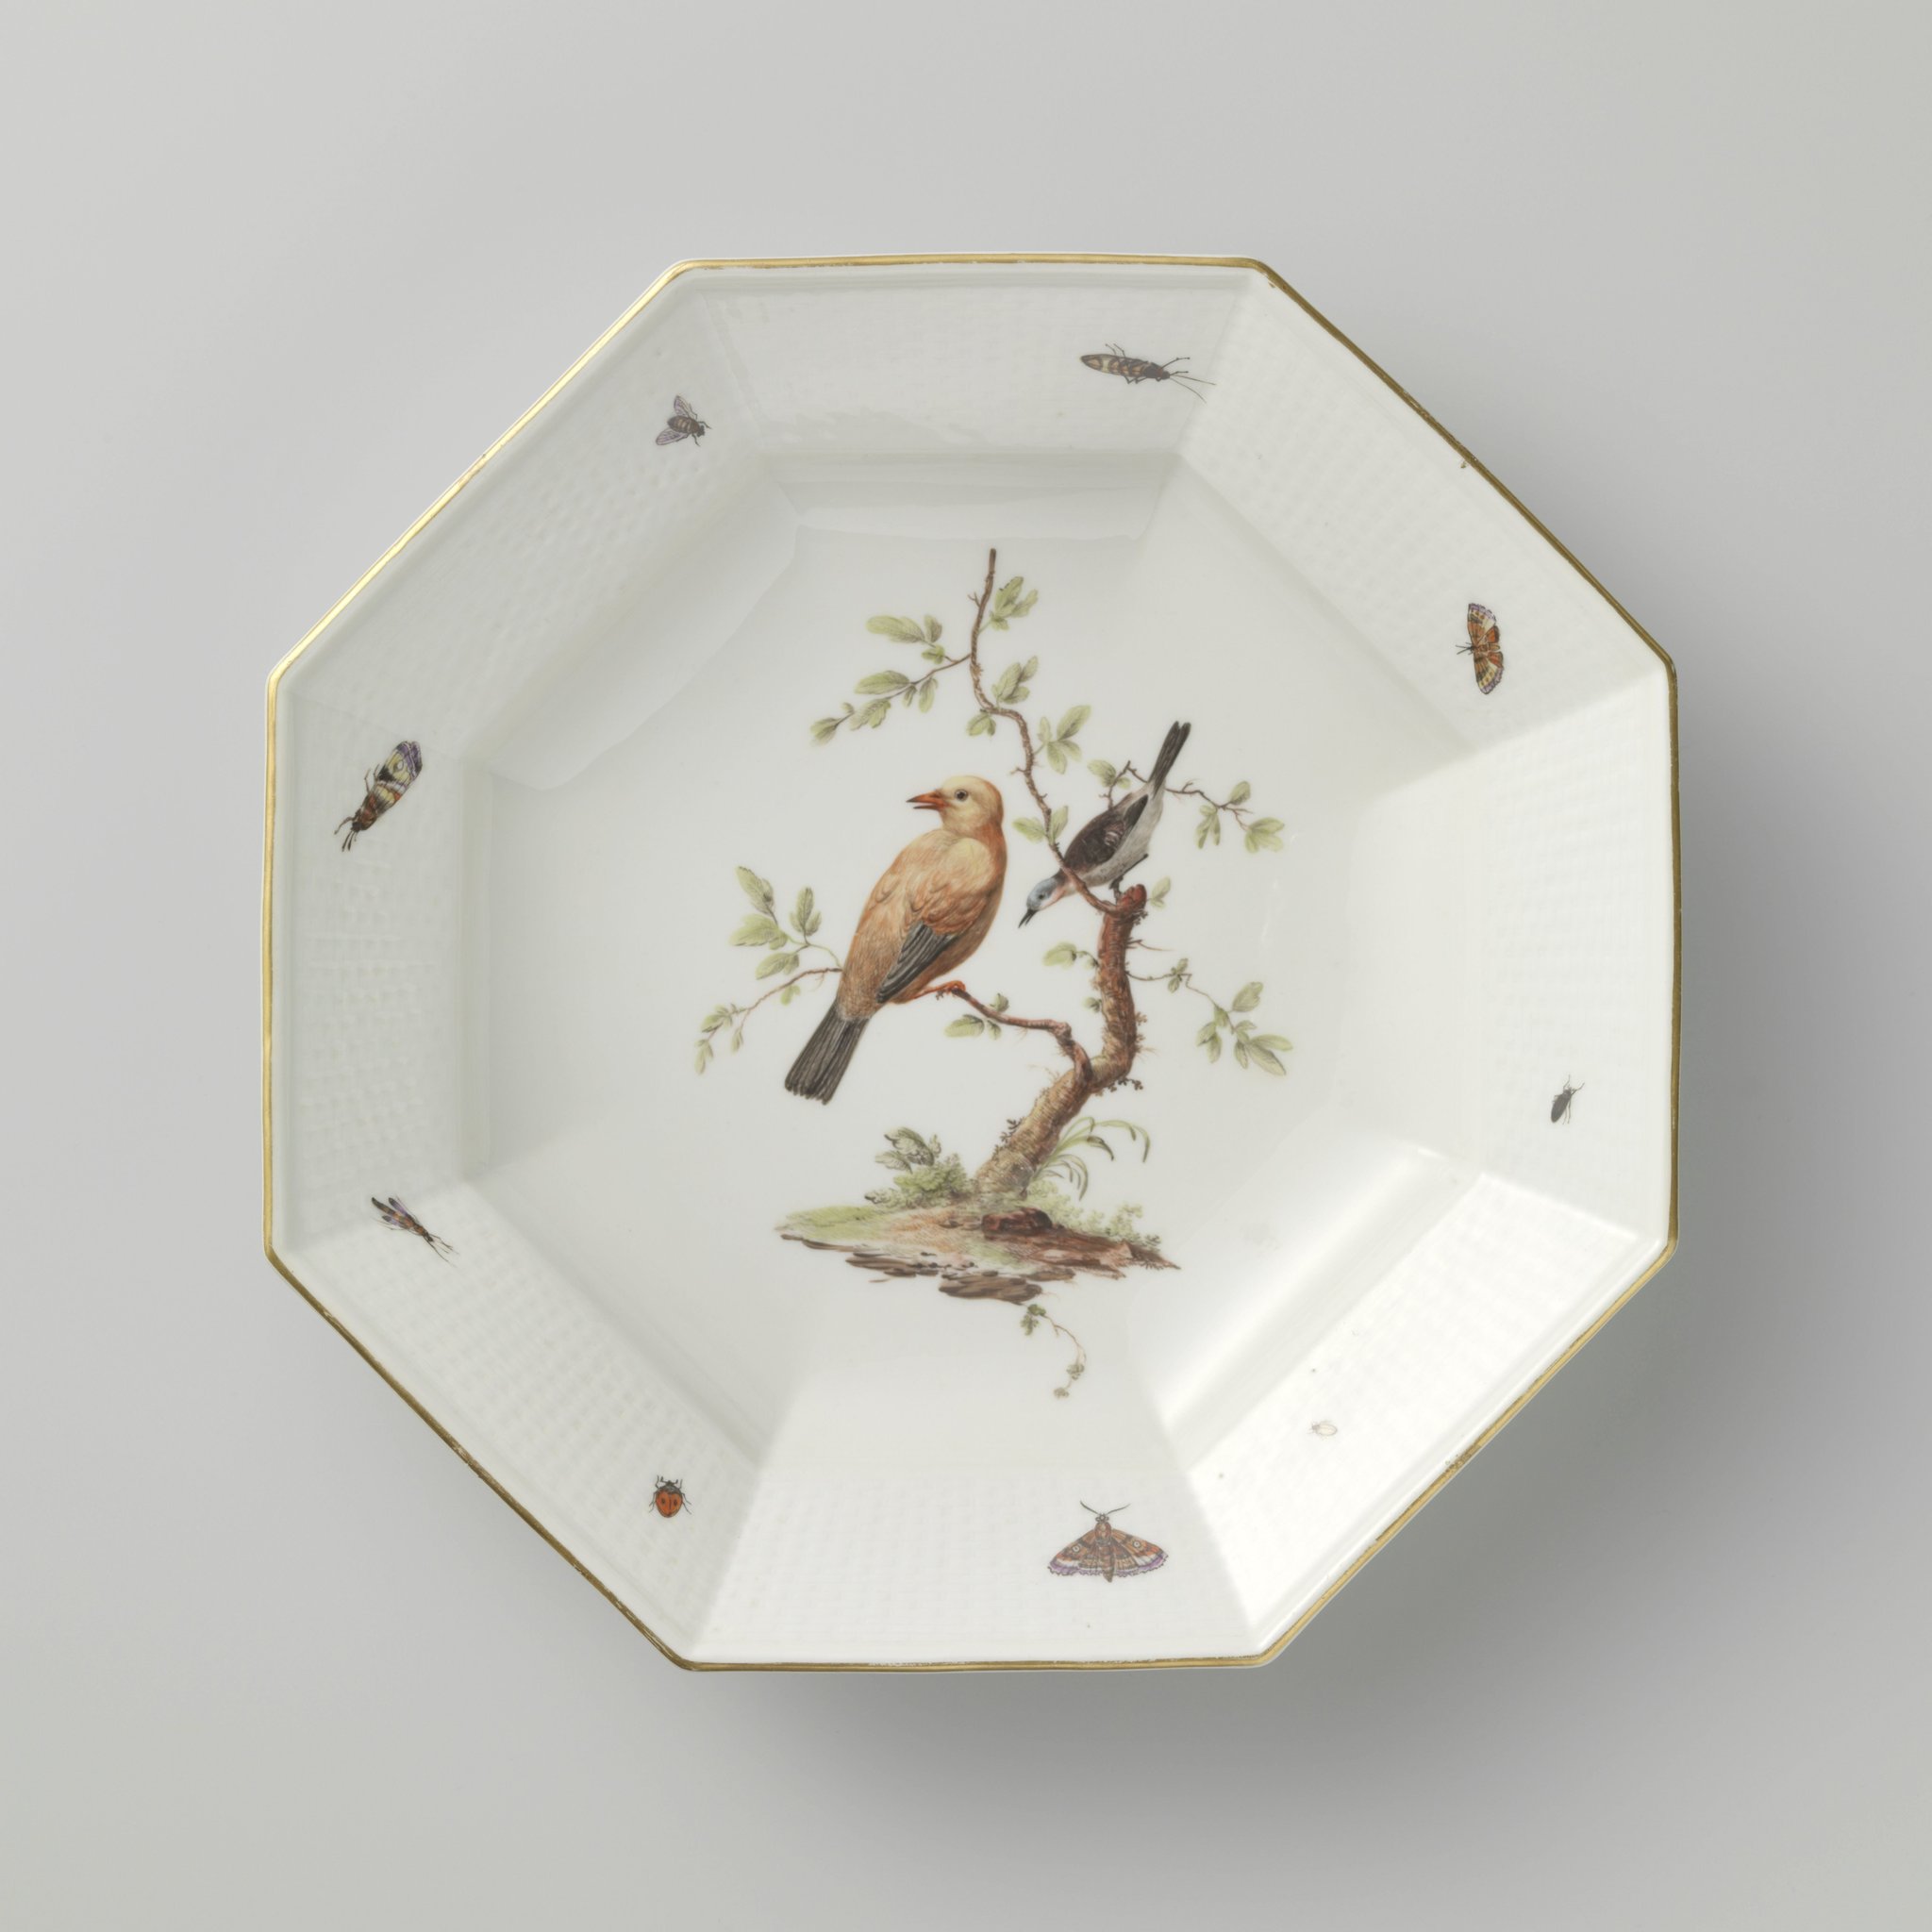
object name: plate dish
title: Bord, achtkantig, op het plat beschilderd met twee vogels en een tak. Rand met vlechtwerk in reliëf, beschilderd met insekten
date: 1784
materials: porcelain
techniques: painted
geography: loosdrecht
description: Two octagonal dishes. Porcelain. Ouder-Amstel, c. 1785 - 1790. Factory under the direction of Friedrich Daeuber.